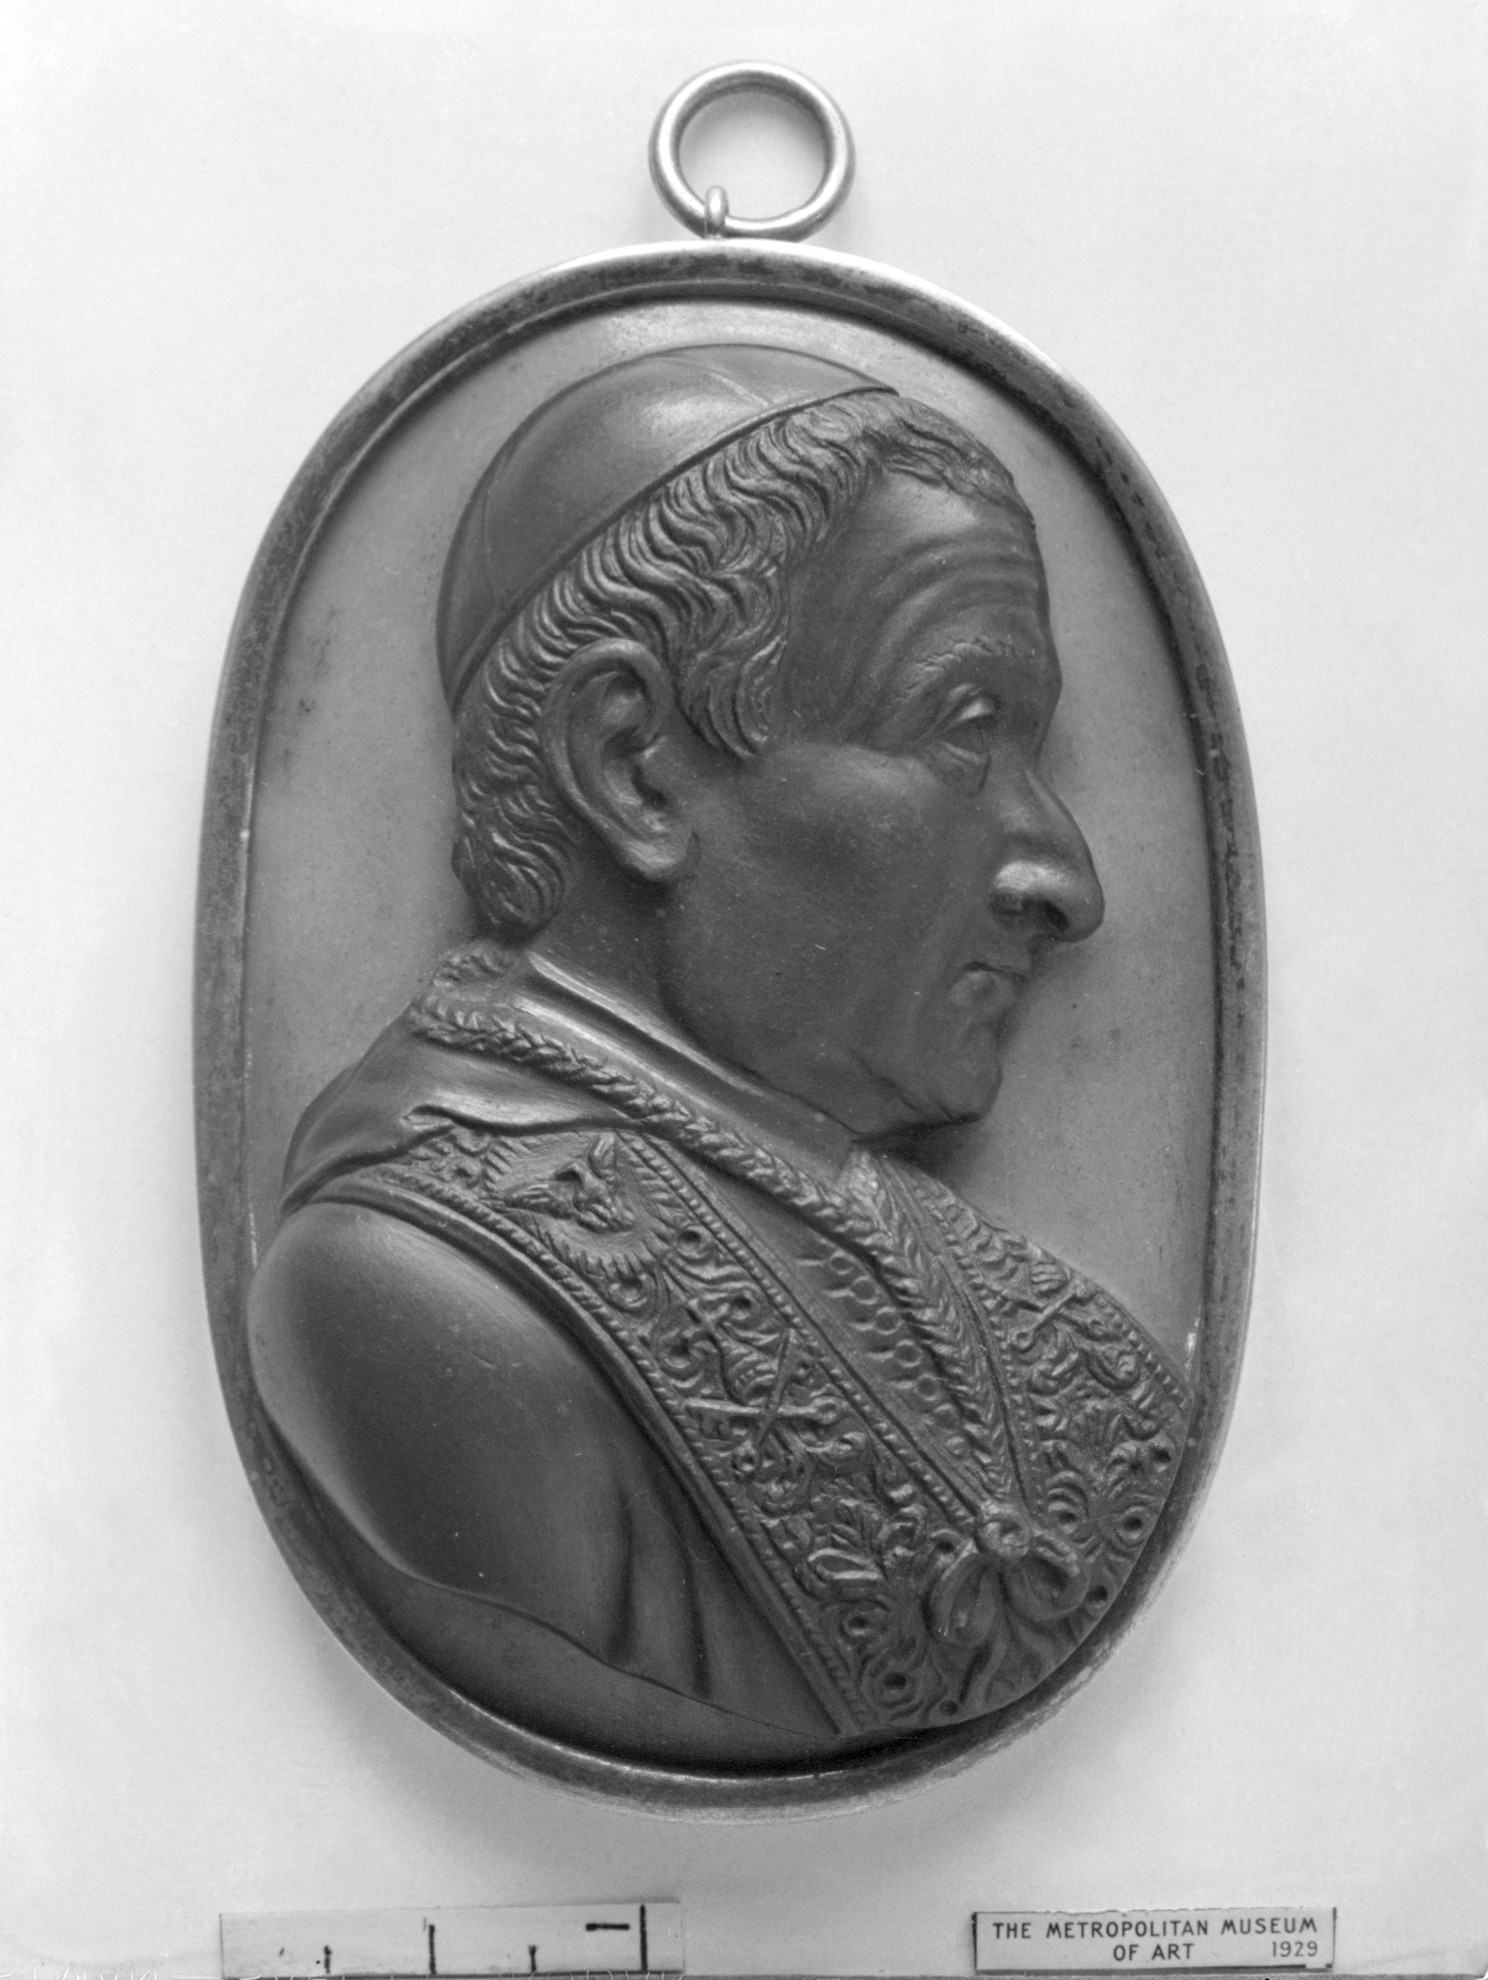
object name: cameo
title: Pope Gregory XVI (Bartolommeo Alberto Cappellari, b. 1765, Pope 1831–1846)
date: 1851-1900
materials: jasper, silver gilt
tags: men,profiles,popes